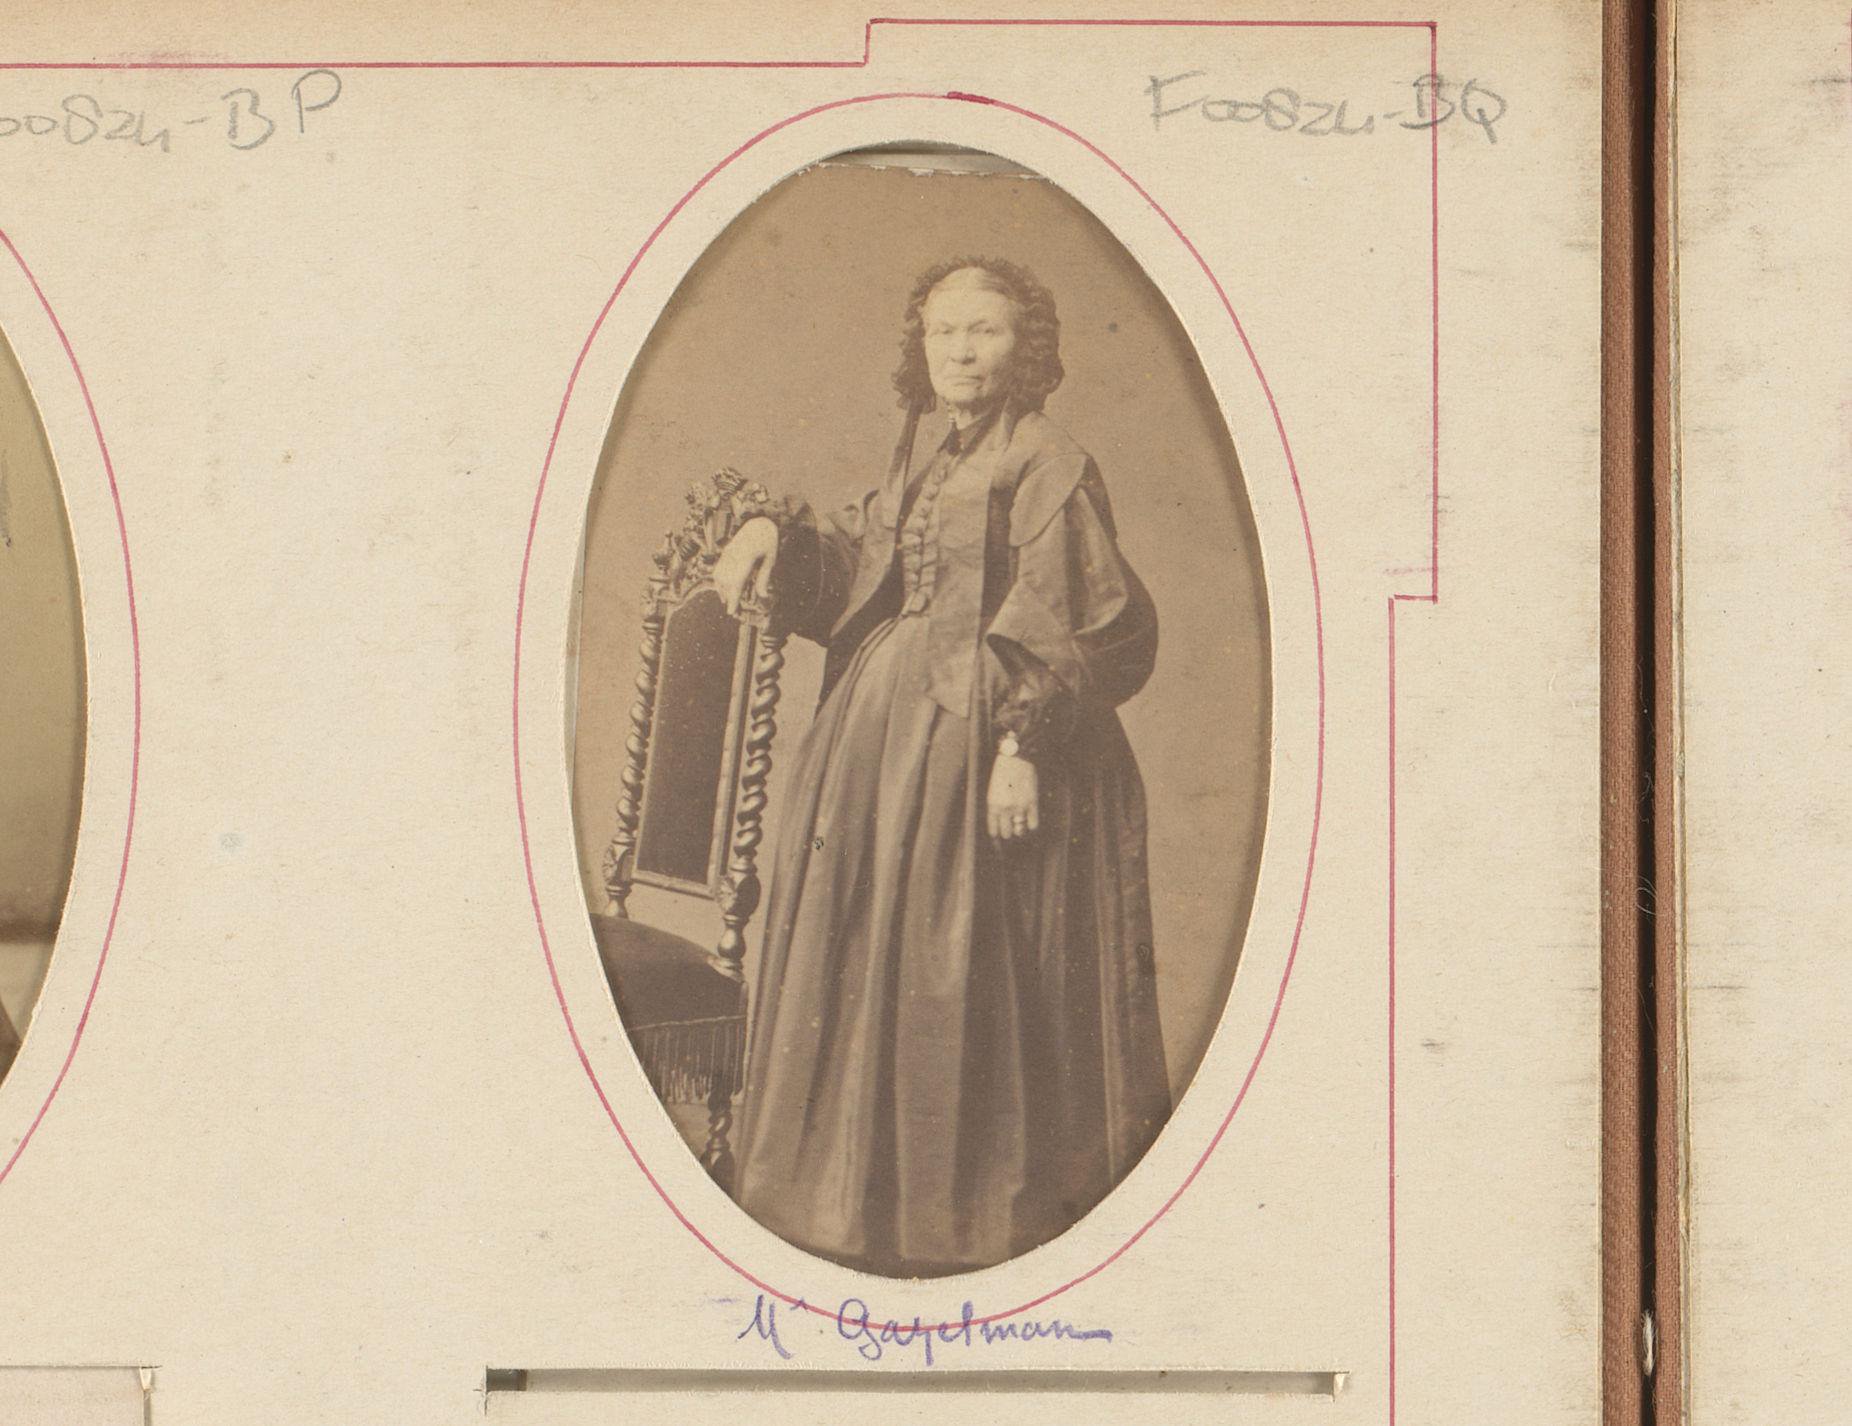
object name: carte de visite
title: Portret van een oude vrouw, aangeduid als Mme. Gayelman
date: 1859-1862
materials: cardboard, paper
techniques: albumen print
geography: paris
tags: adult woman, anonymous historical person portrayed, paris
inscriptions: inscription: ‘SUCCURSALE á BADE.’, address: ‘Place Cadet, 31, Paris.’